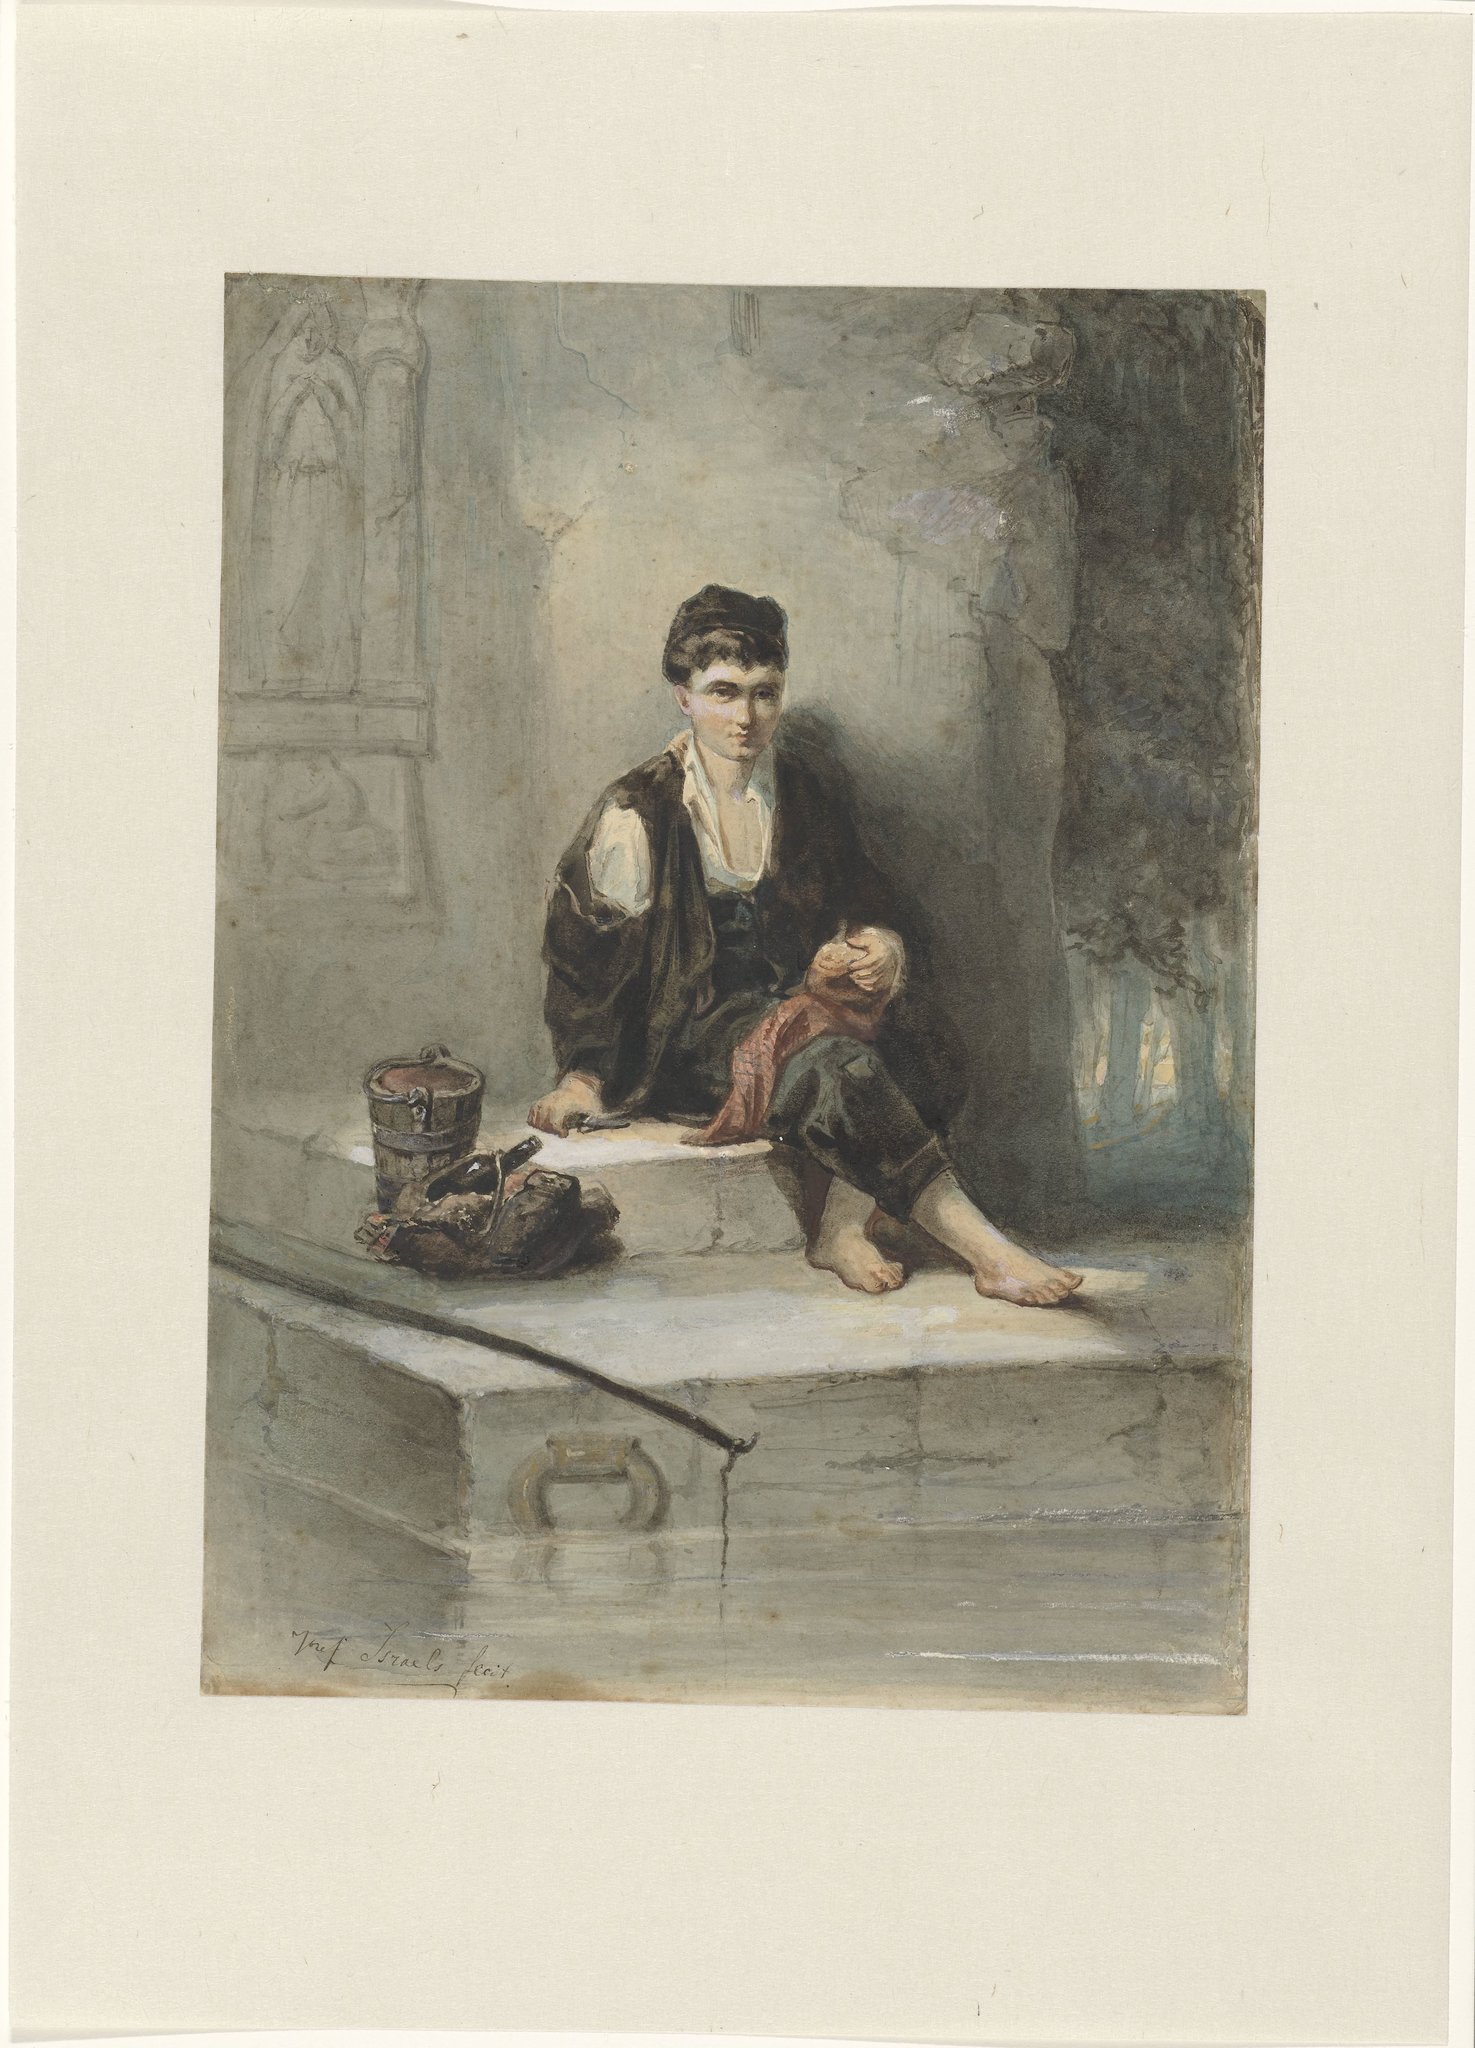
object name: watercolor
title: Zittende vissersknaap aan zijn maaltijd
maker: jozef israëls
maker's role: draughtsman, painter, print maker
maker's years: 1824-1911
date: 1834-1911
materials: ink, paper, watercolor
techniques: brush, pen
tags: eating